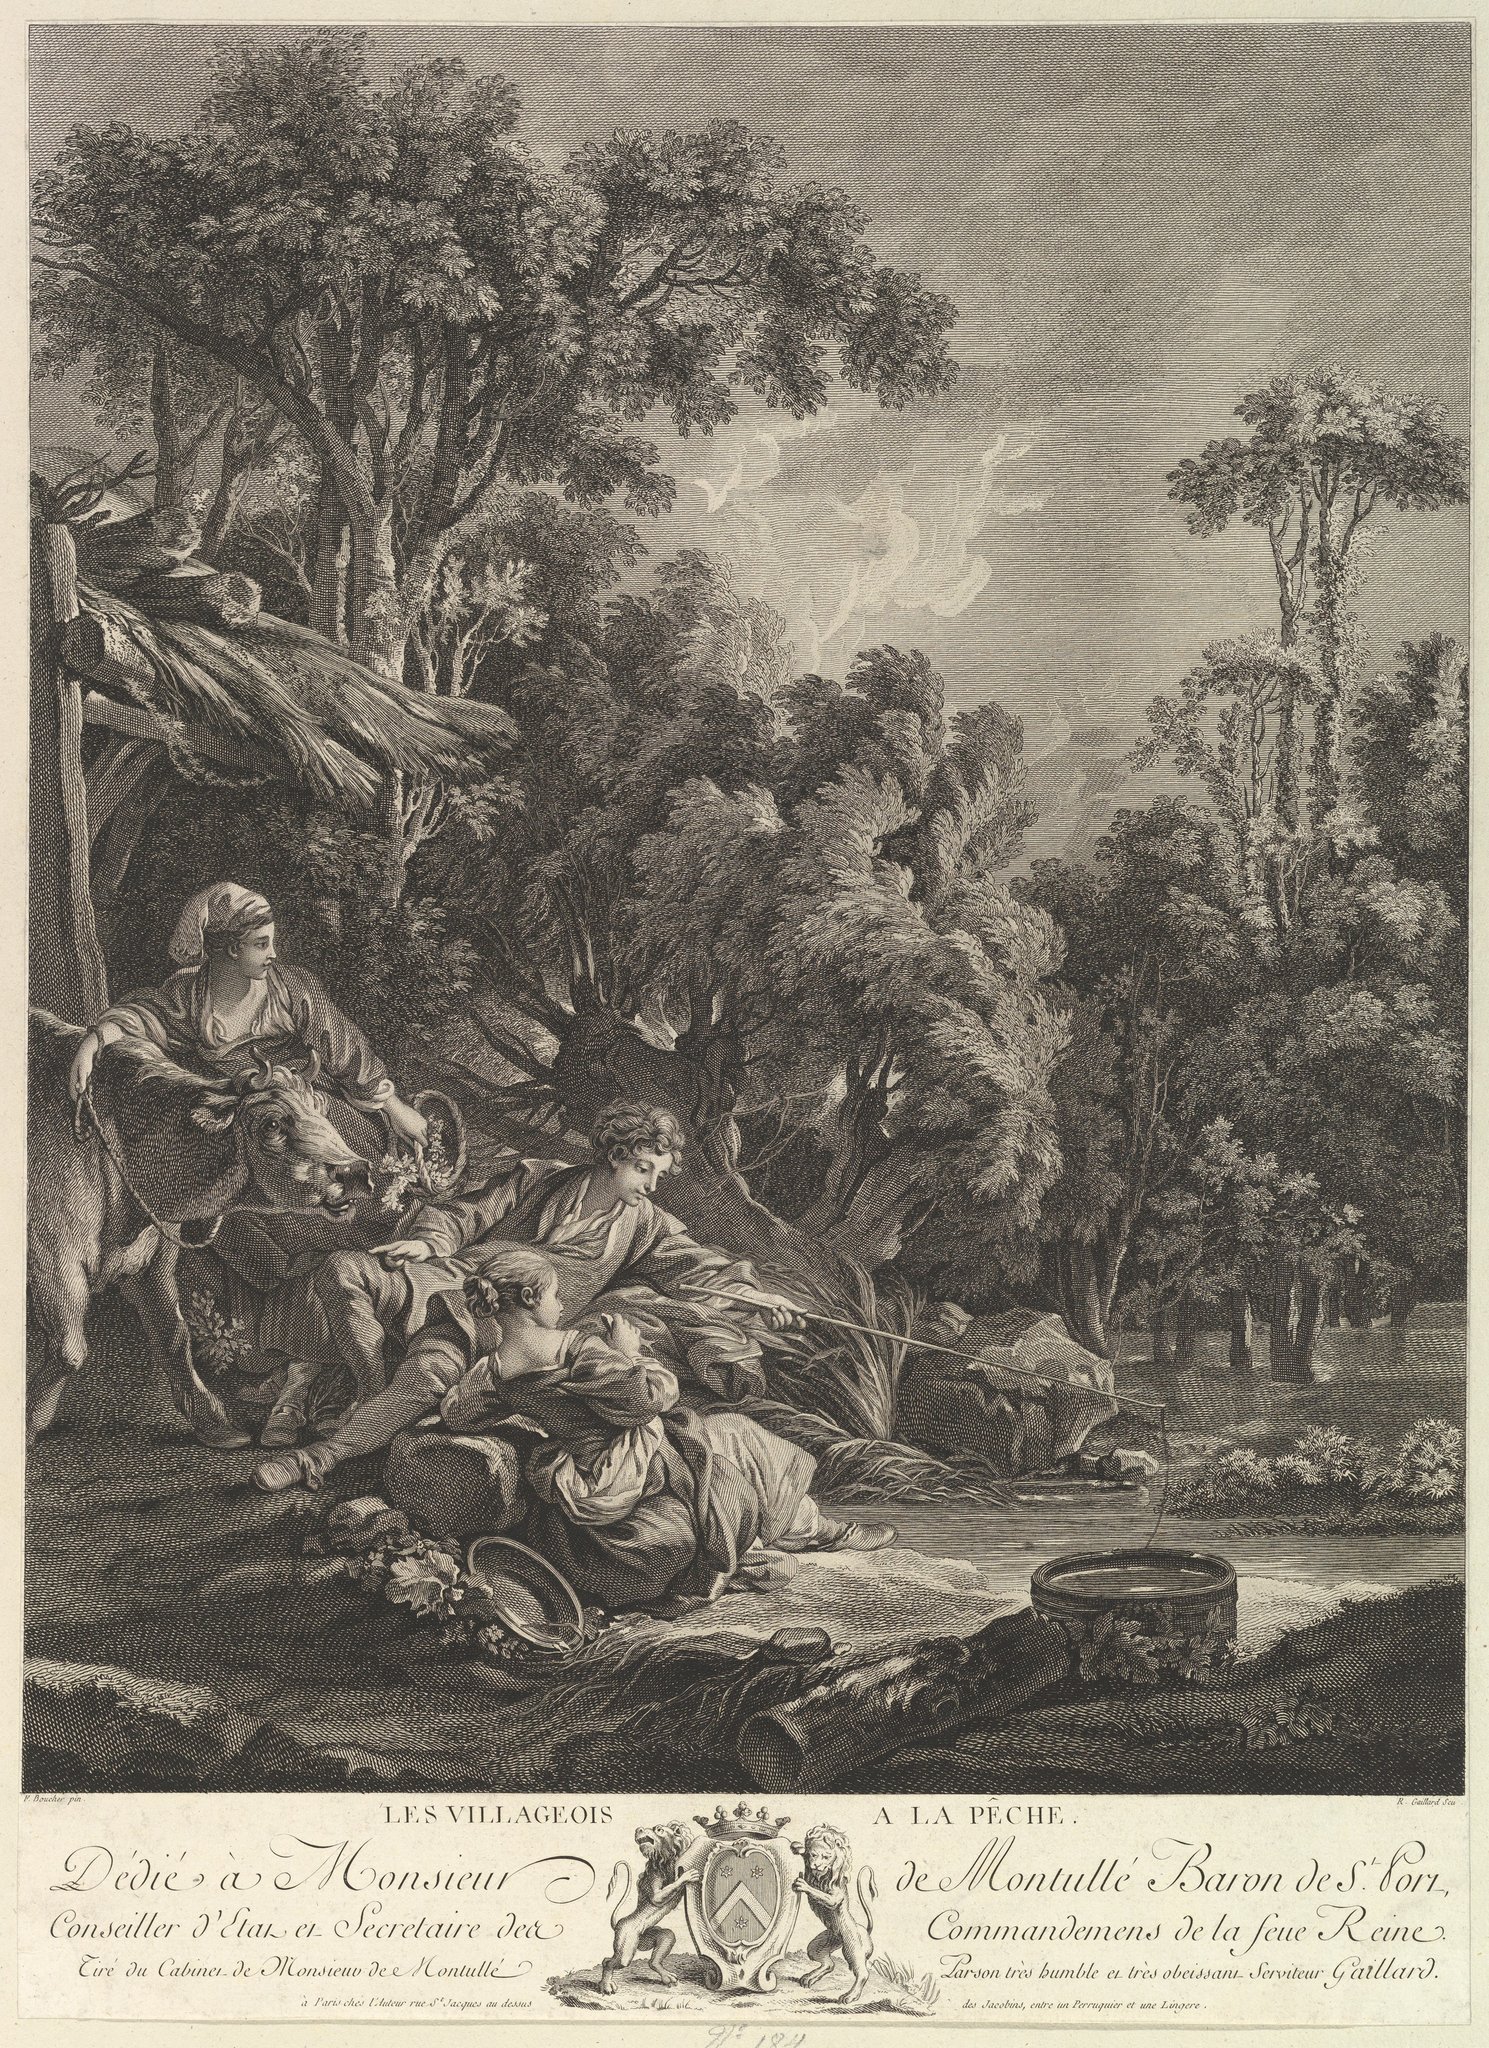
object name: print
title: Les Villagois à la Pêche (The Villages Fishing)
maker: rené gaillard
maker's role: artist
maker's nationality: french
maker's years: 1714-1790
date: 1701-1800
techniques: engraving, etching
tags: animals,women,fishing